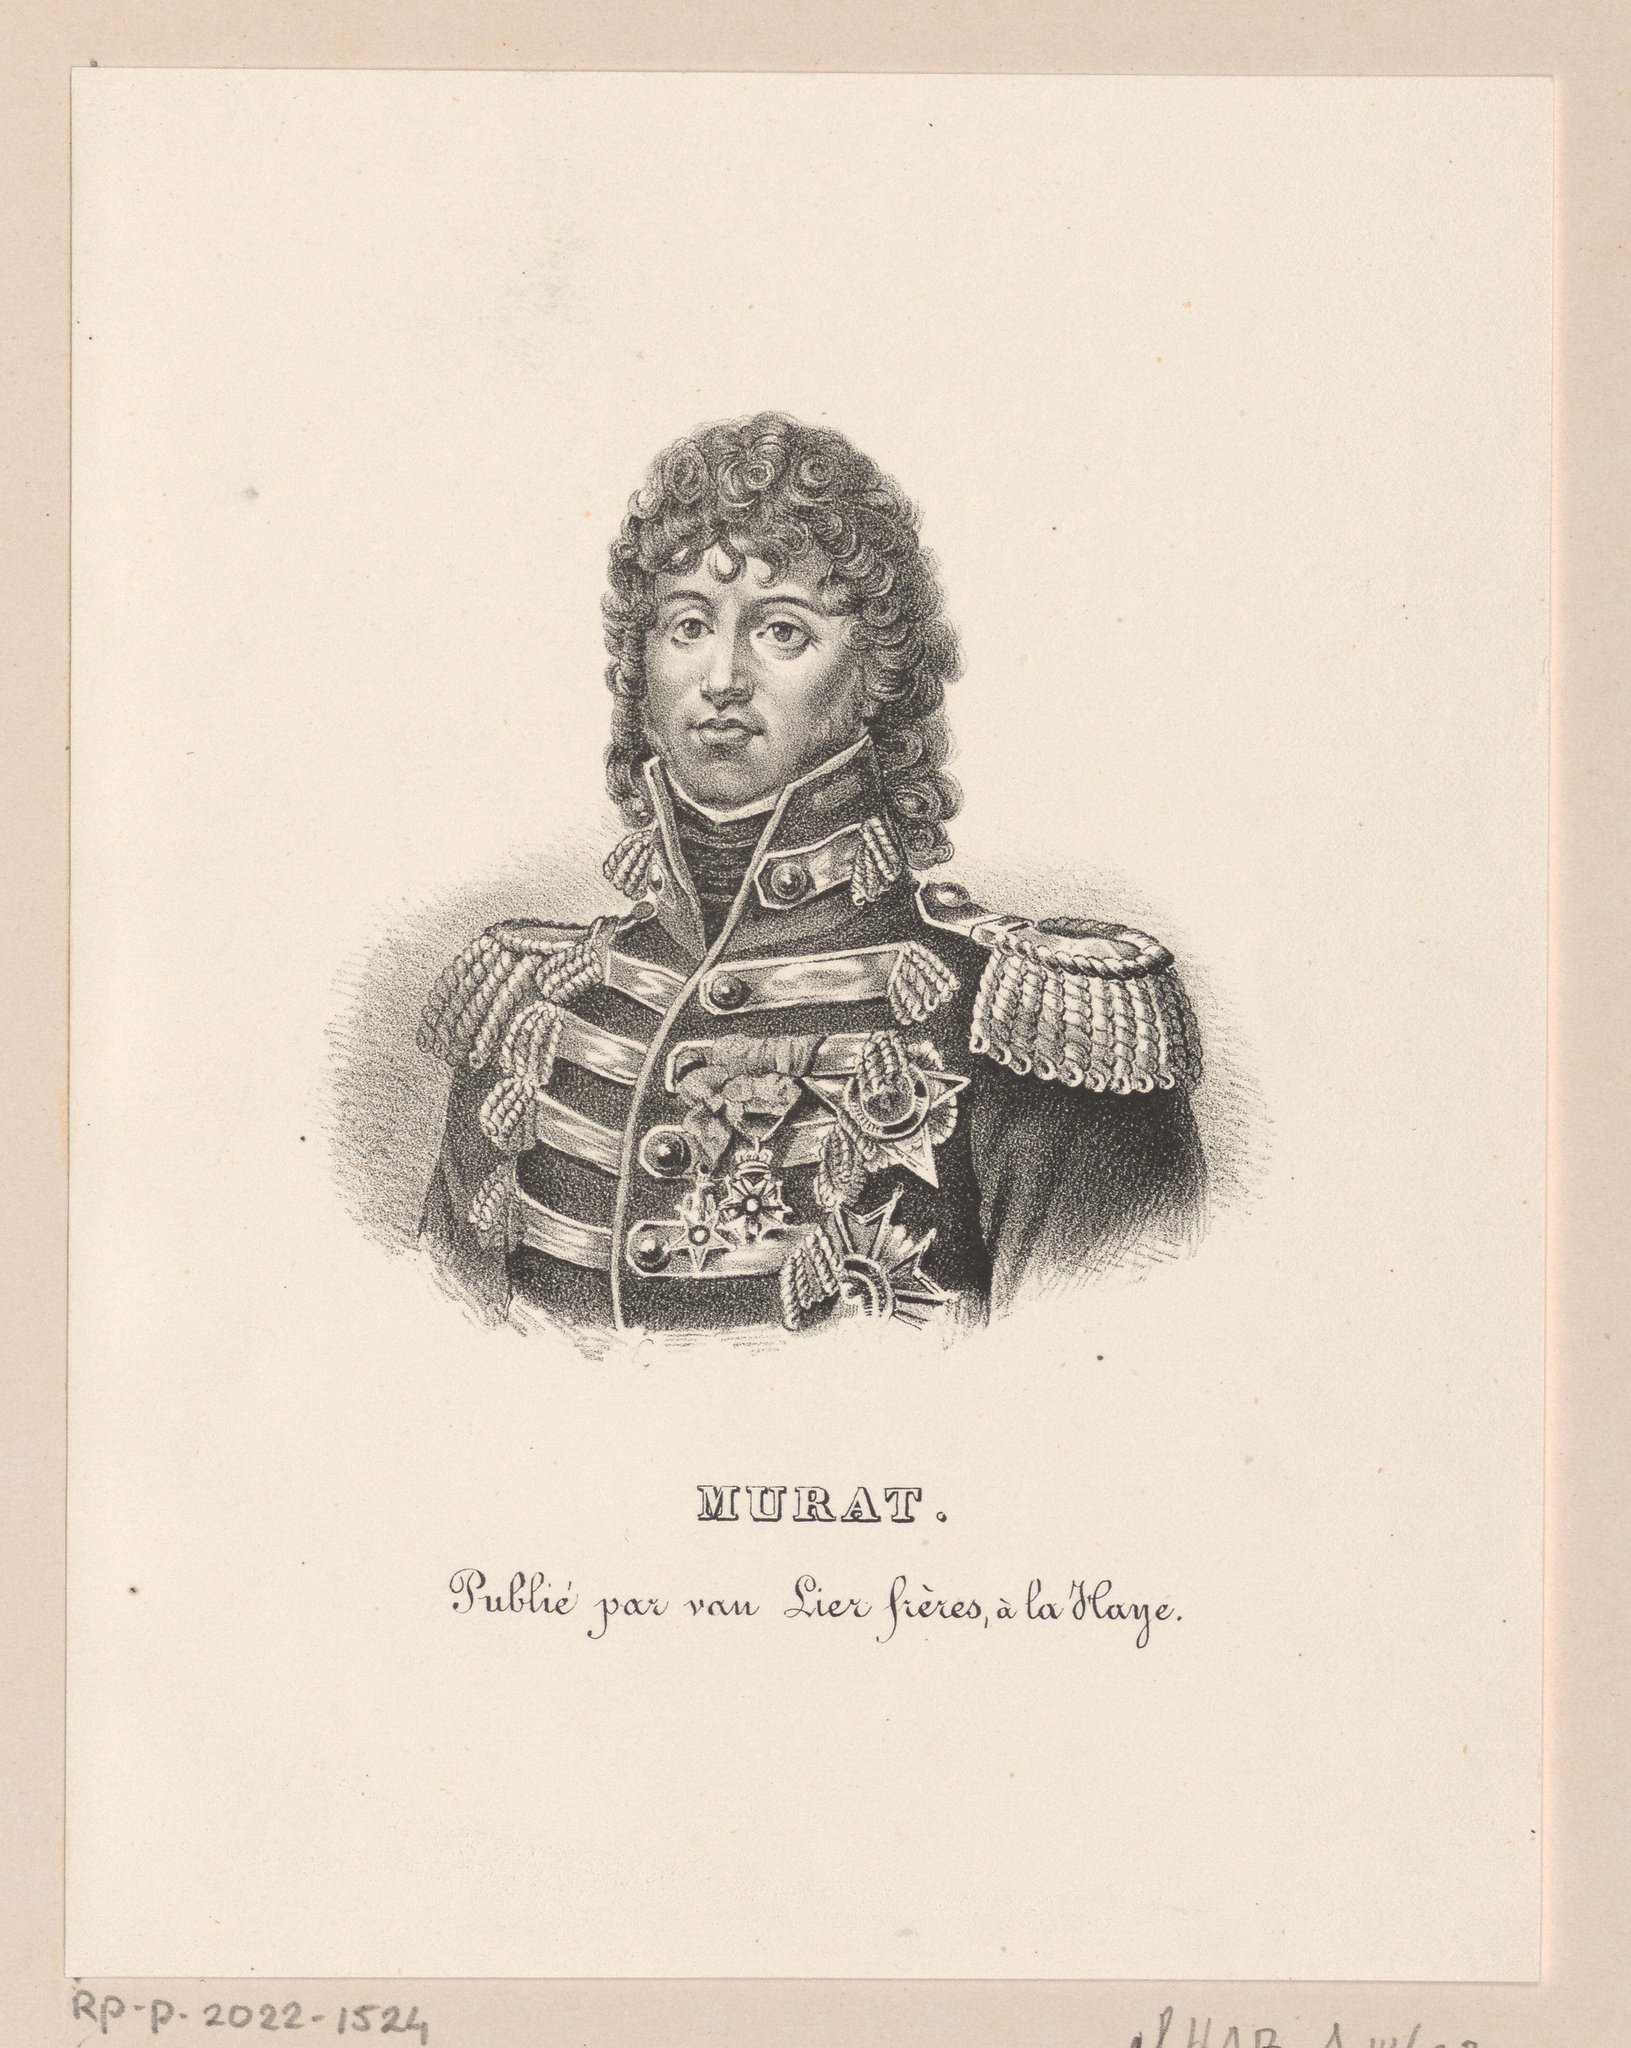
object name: print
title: Portret van Joachim Murat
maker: Anonymous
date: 1833-1846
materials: paper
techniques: lithograph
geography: the hague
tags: historical persons, emperor